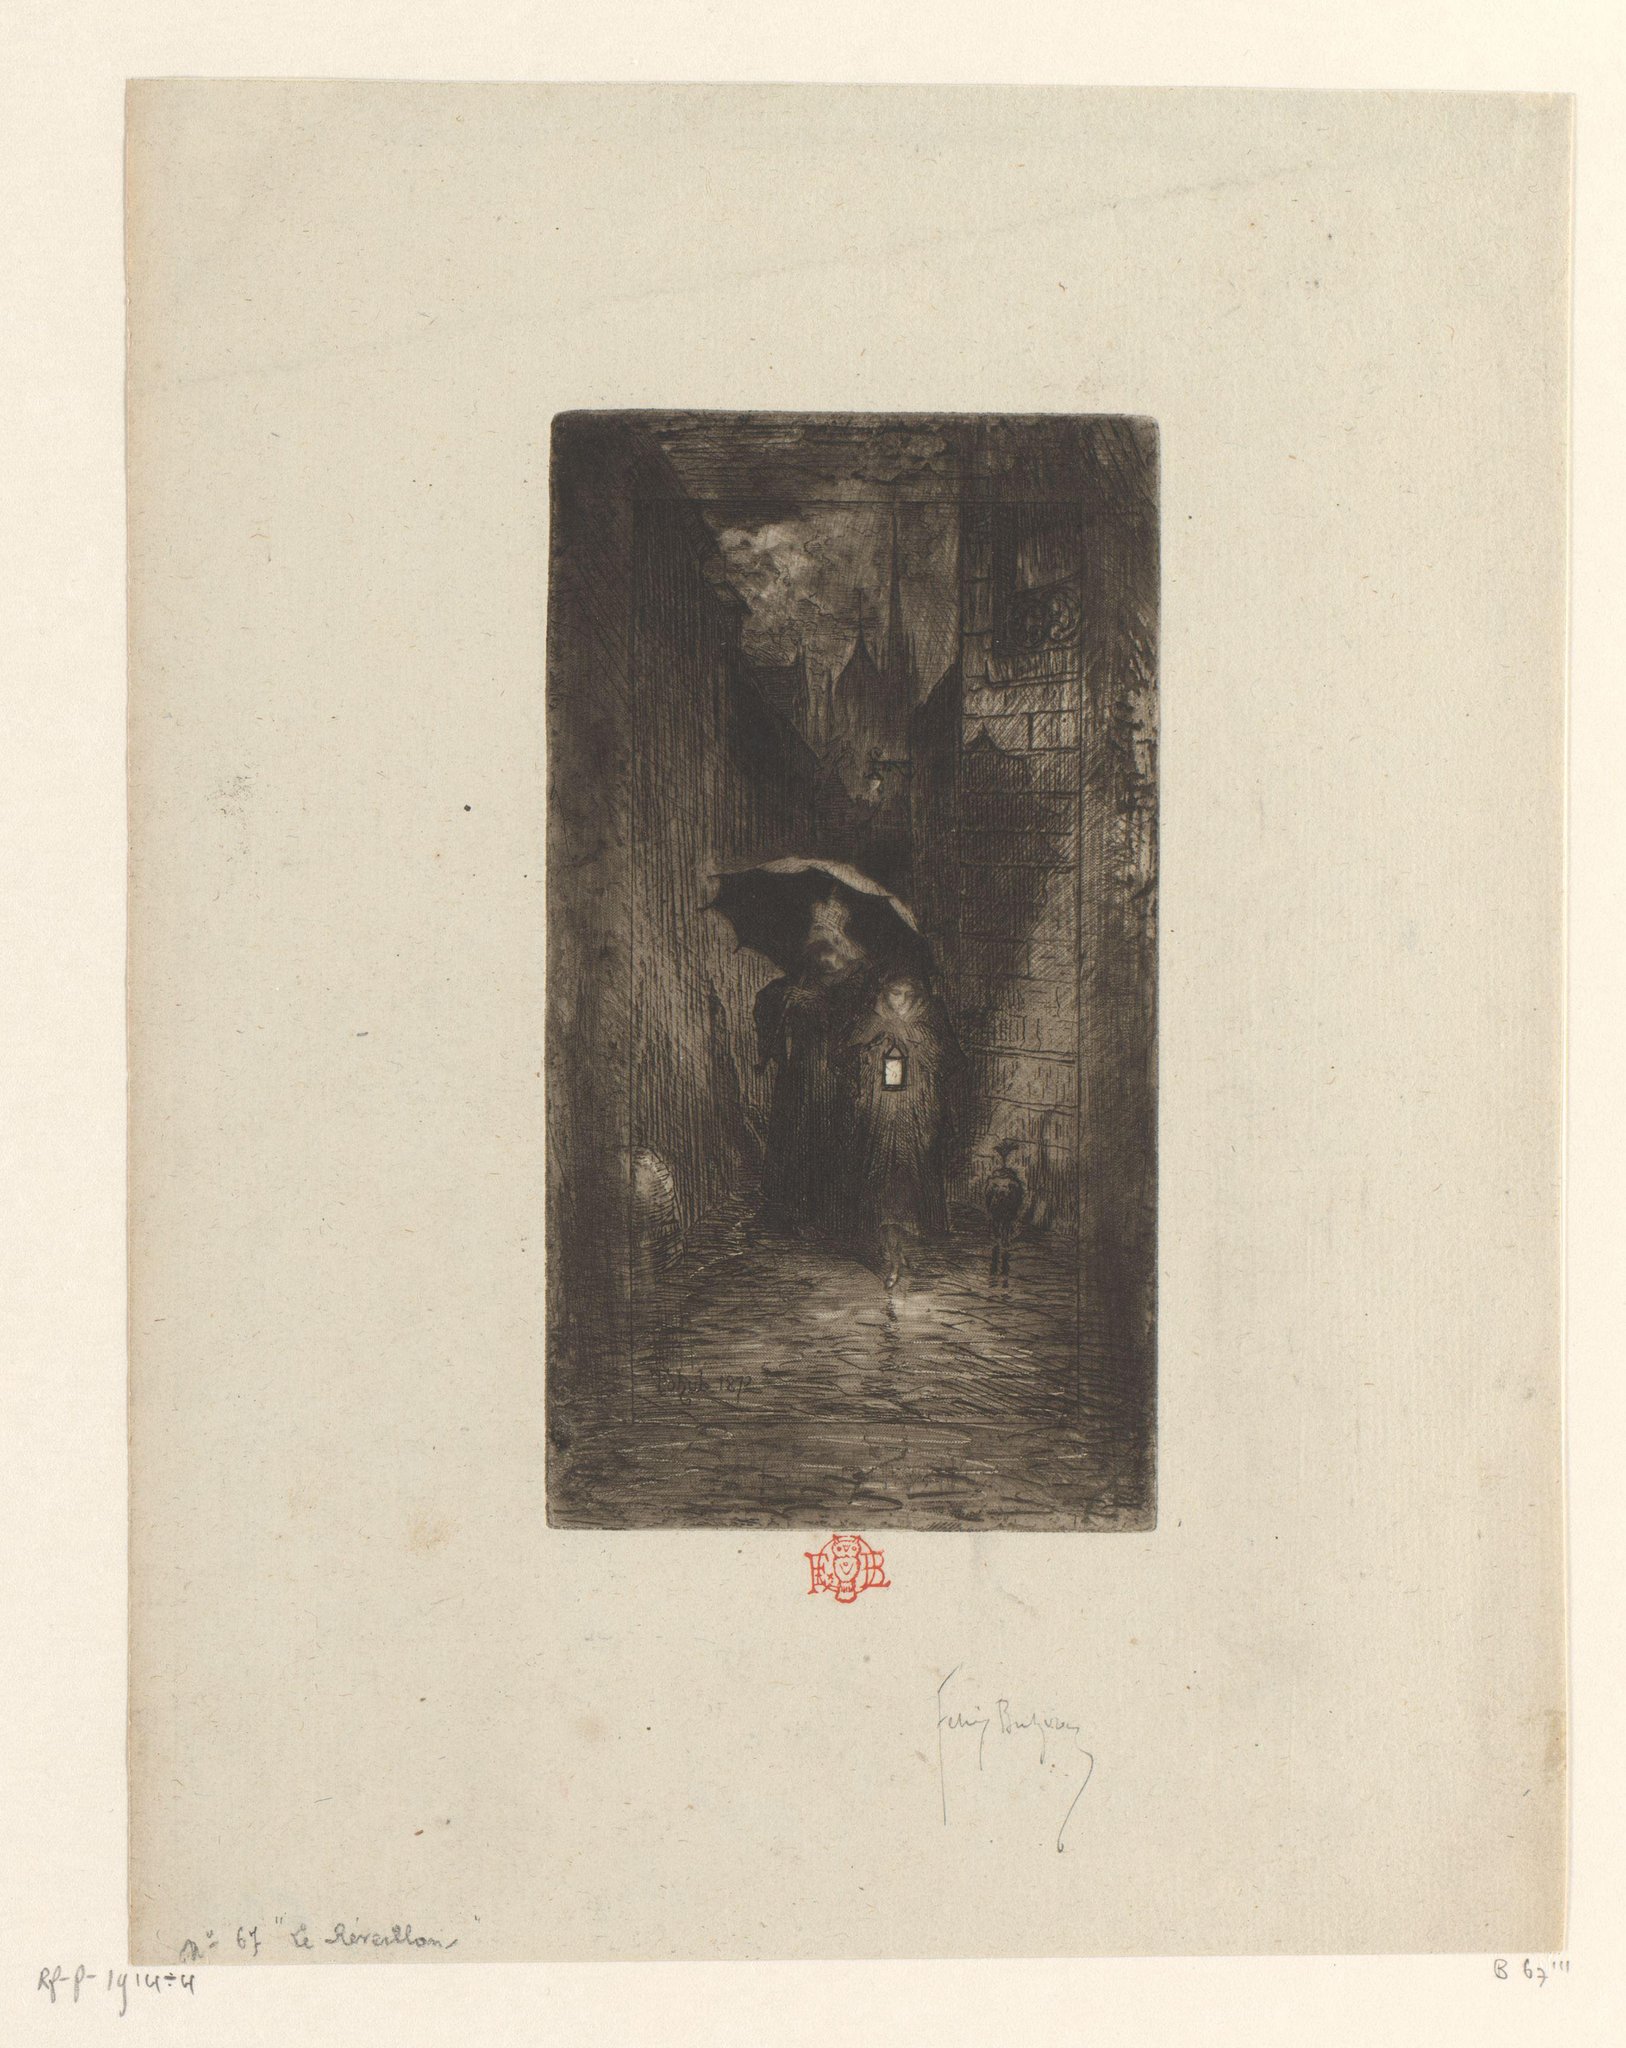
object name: print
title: Twee vrouwen in een donkere steeg met een lantaarn in de regen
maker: félix hilaire buhot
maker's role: draughtsman, print maker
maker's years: 1847-1898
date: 1872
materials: paper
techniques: aquatint, drypoint, etching, roulette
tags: adult woman, rain, lantern, village lane, alley, night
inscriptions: : ‘No. 67 "Le Réveillon"’, stamp: Lugt 977, collector's mark: Lugt 2228, signature